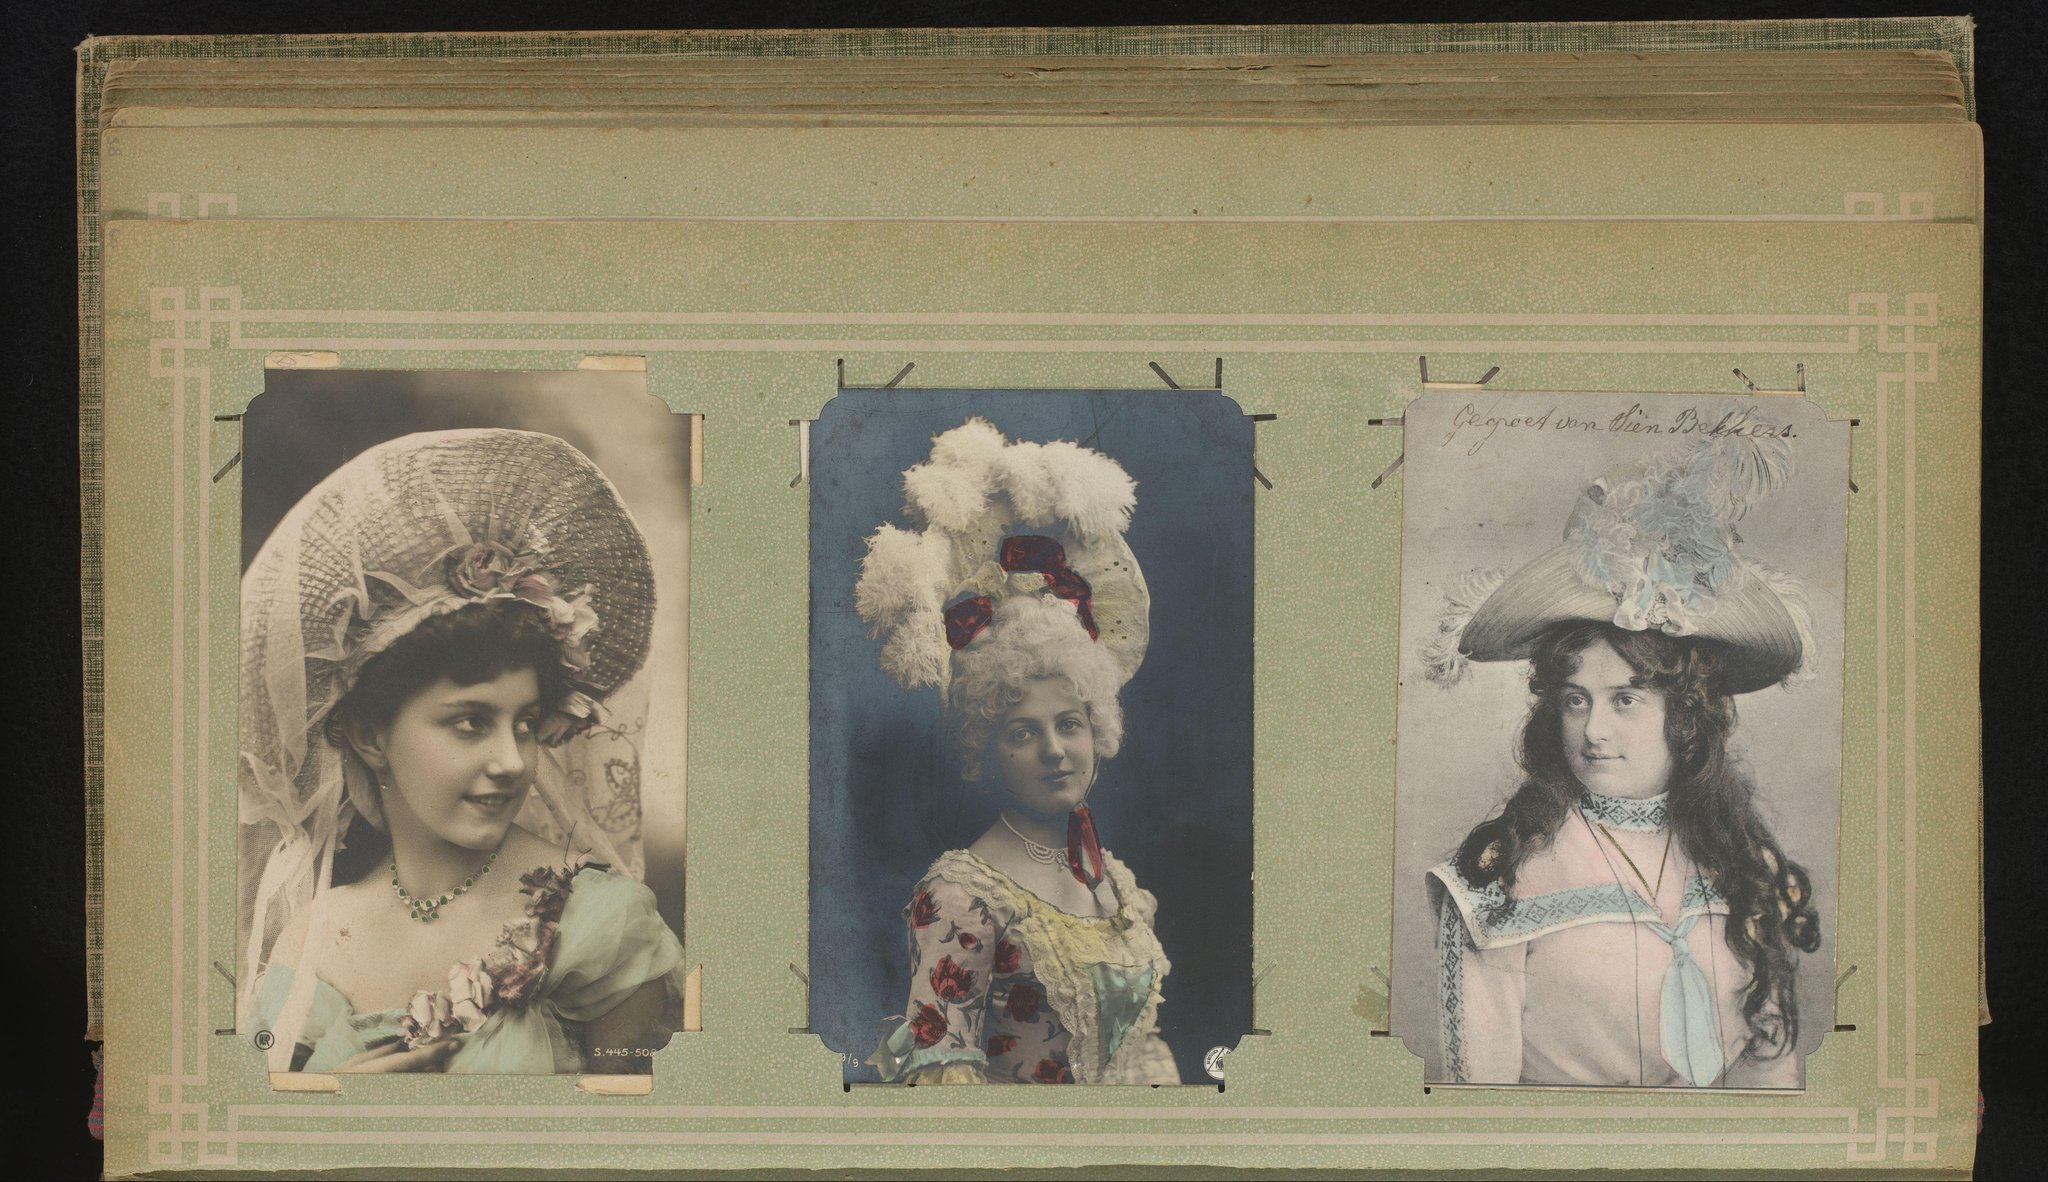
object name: album leaf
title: Drie portretten van vrouwen met hoed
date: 1900-1930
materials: cardboard, photographic support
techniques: photograph, gelatin silver print, hand coloring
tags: historical persons - bb - woman, head-gear: hat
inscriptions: monogram: ‘R/ [p]/ H’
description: Deze foto's en prent maken deel uit van een album.